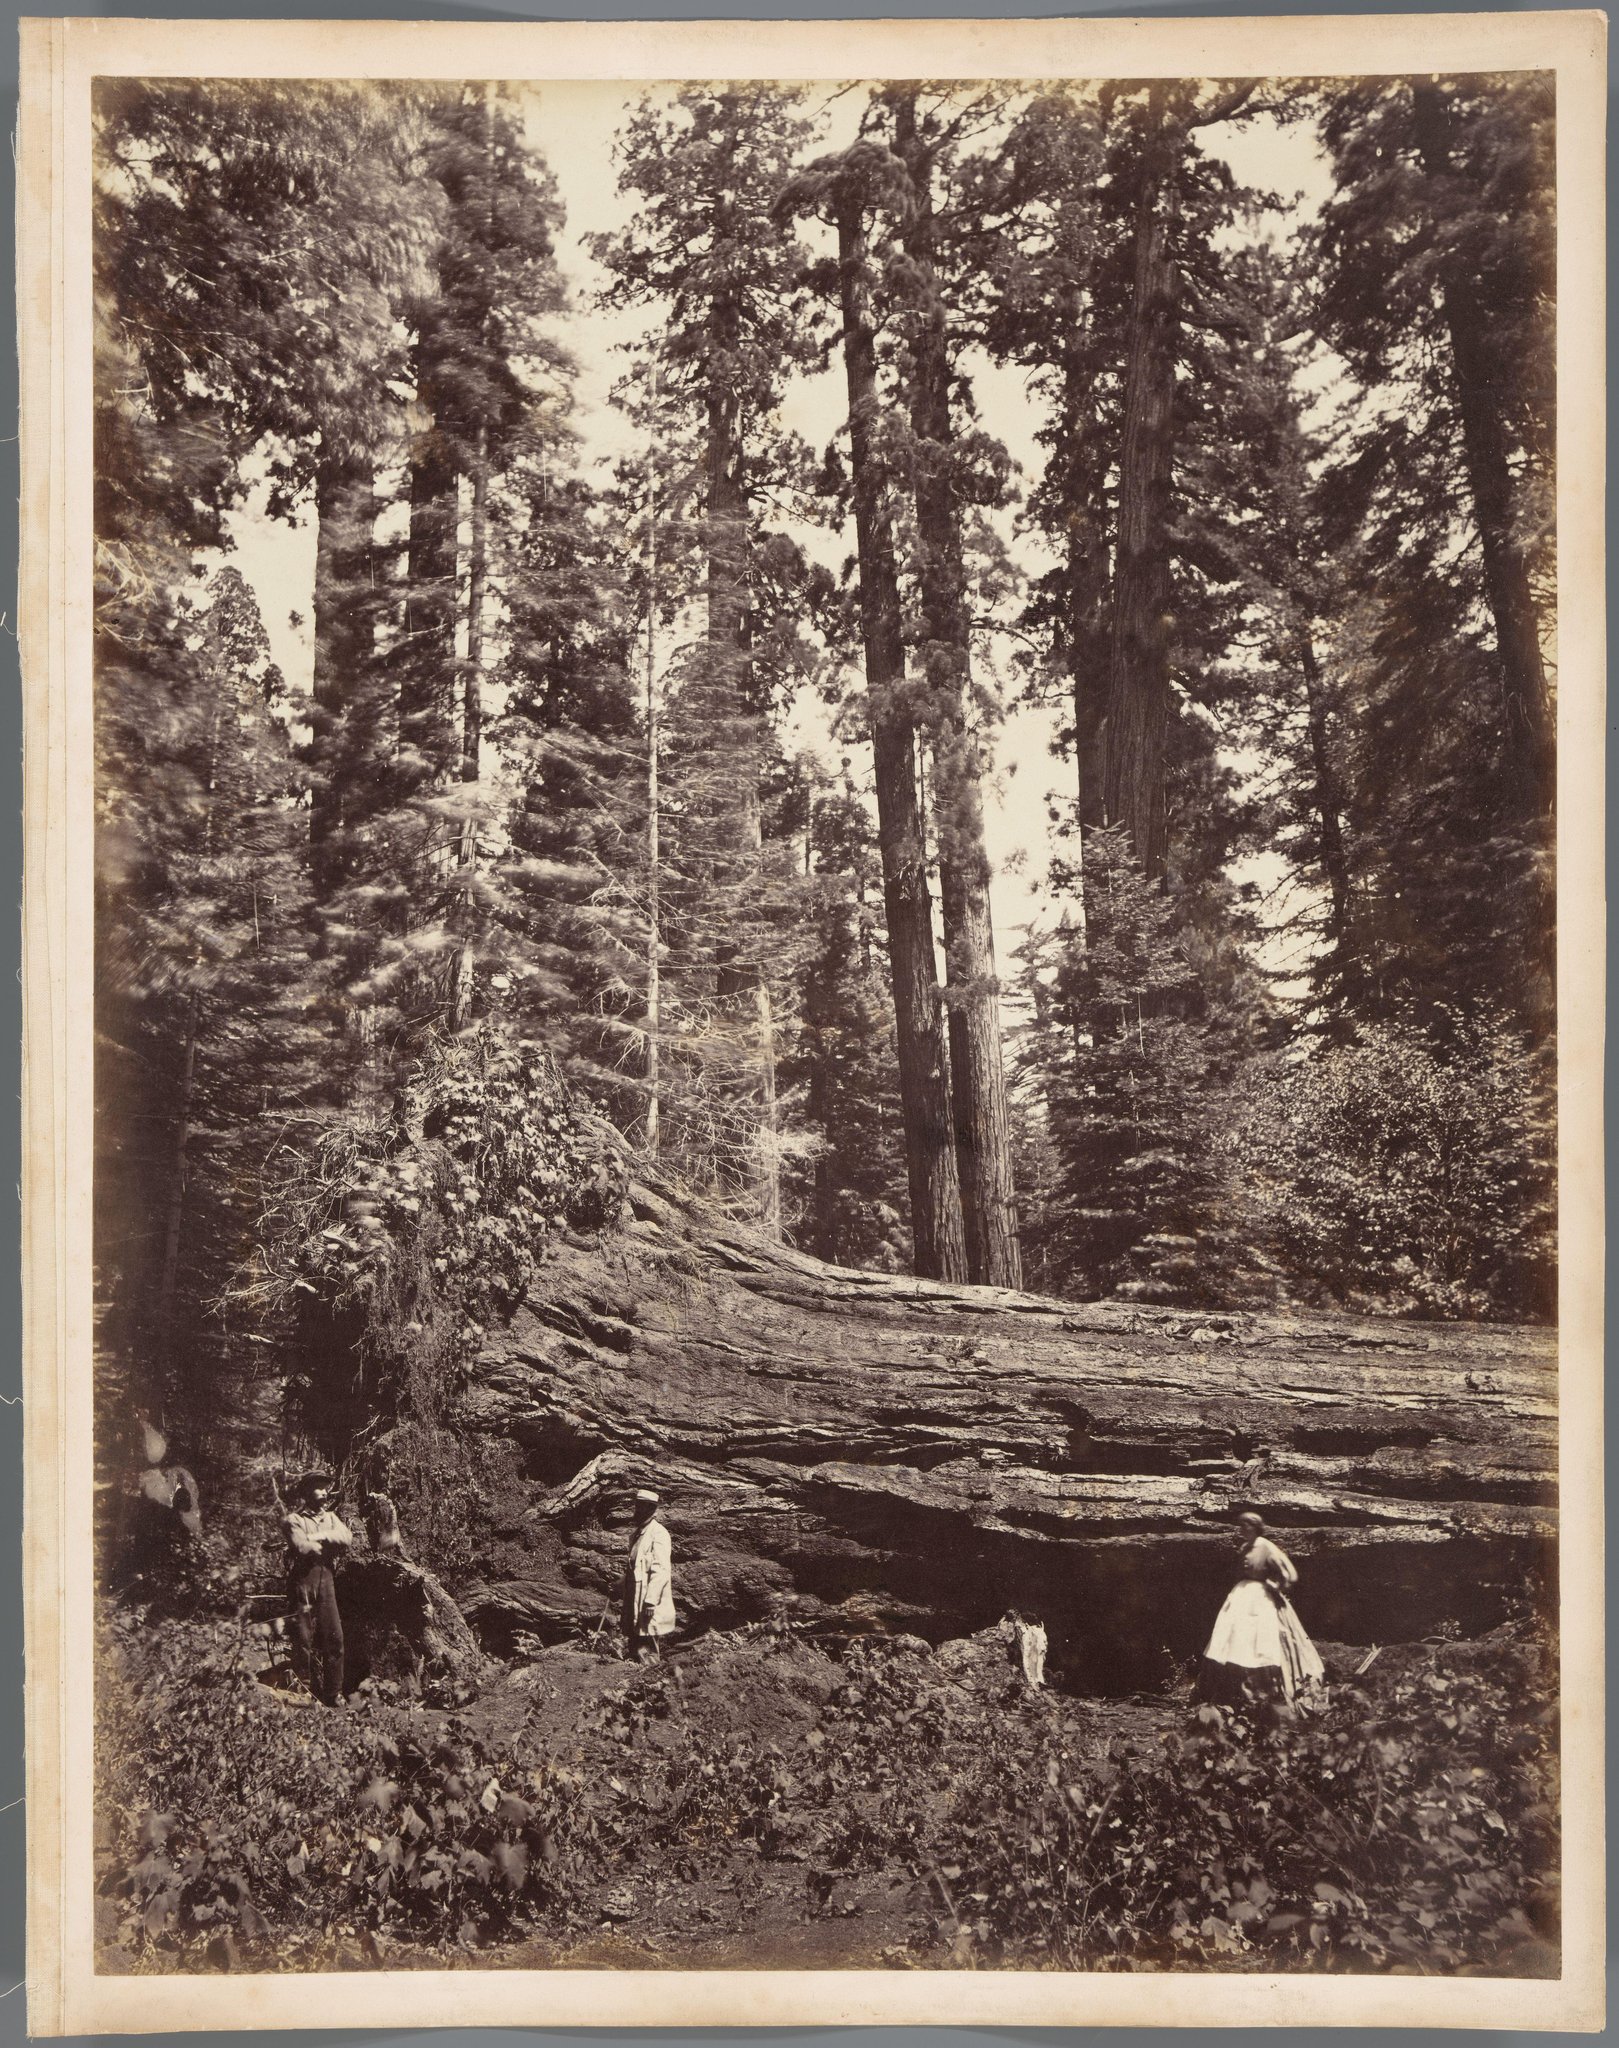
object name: photograph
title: Fallen Tree Hercules 325 feet long, Mammoth Grove, Calaveras County, California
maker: charles leander weed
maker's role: fotograaf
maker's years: 1824-1903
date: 1864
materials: paper, photographic support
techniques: albumen print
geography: san francisco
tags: united states of america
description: Groep mensen bij de 99 meter hoge, omgevallen boom genaamd 'Hercules' in Mammoth Grove in Calaveras County in Californië. De reuzenboom viel in 1861 neer en is vaker in prent gebracht en gefotografeerd.